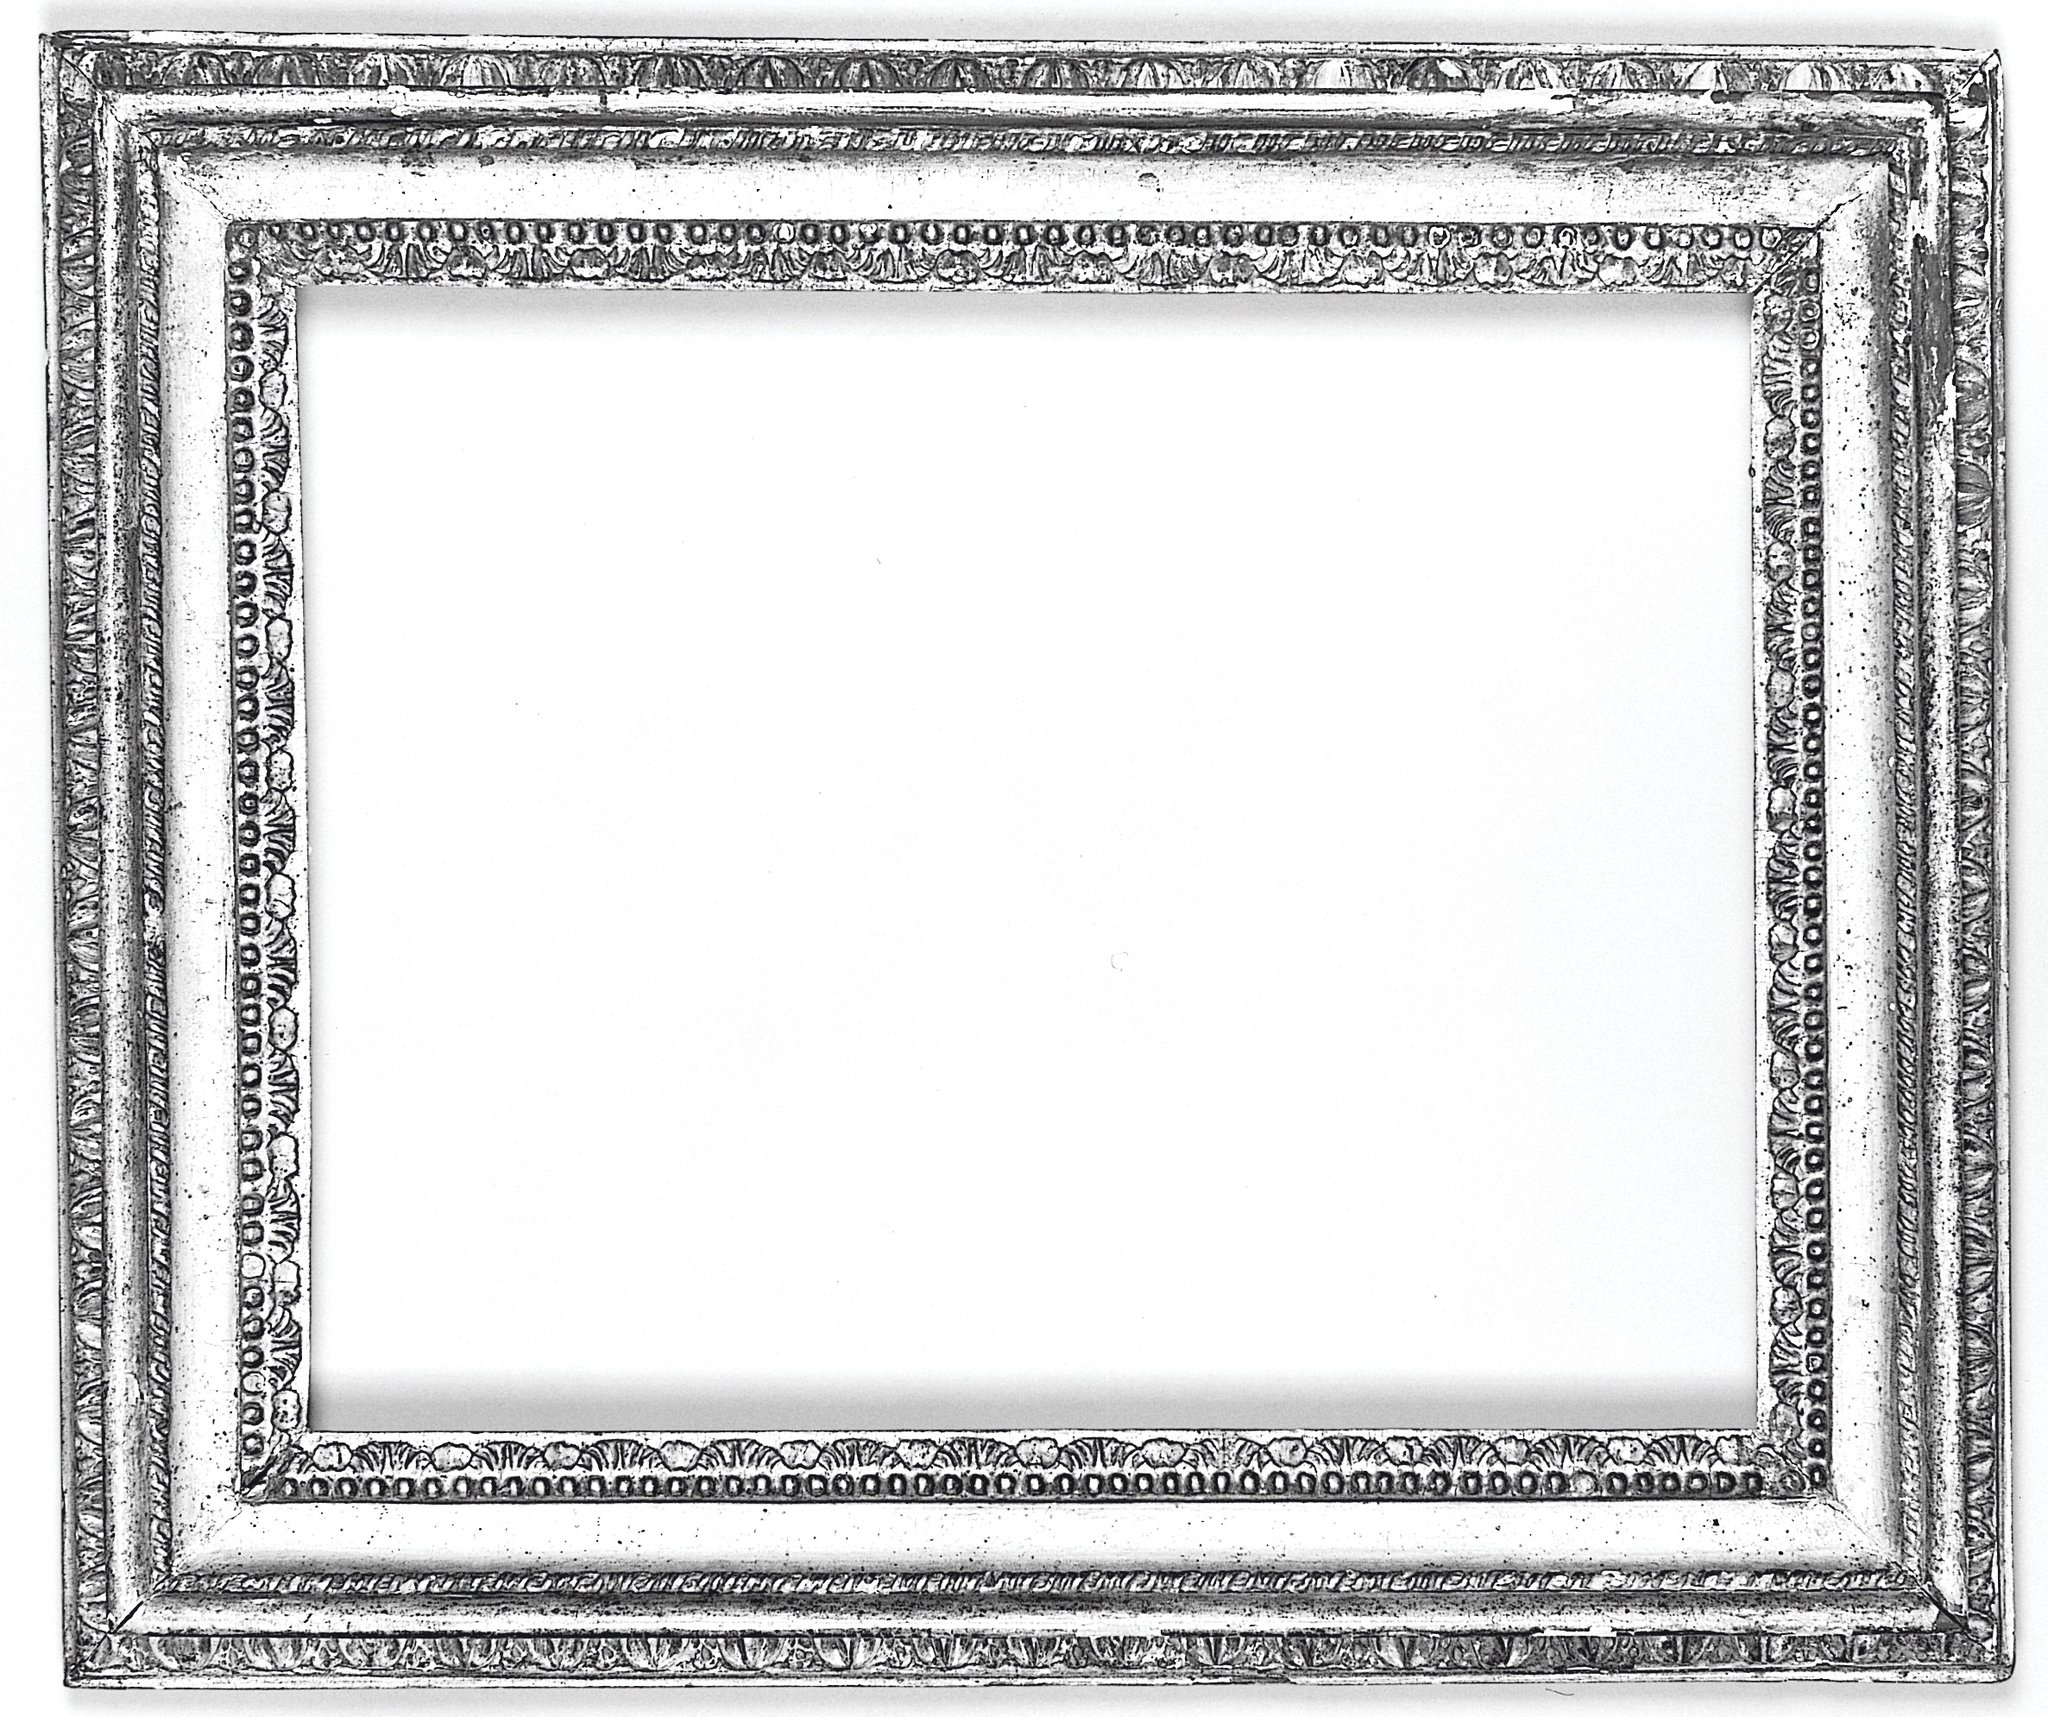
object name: frame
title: Salvator Rosa frame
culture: italian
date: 1740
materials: wood